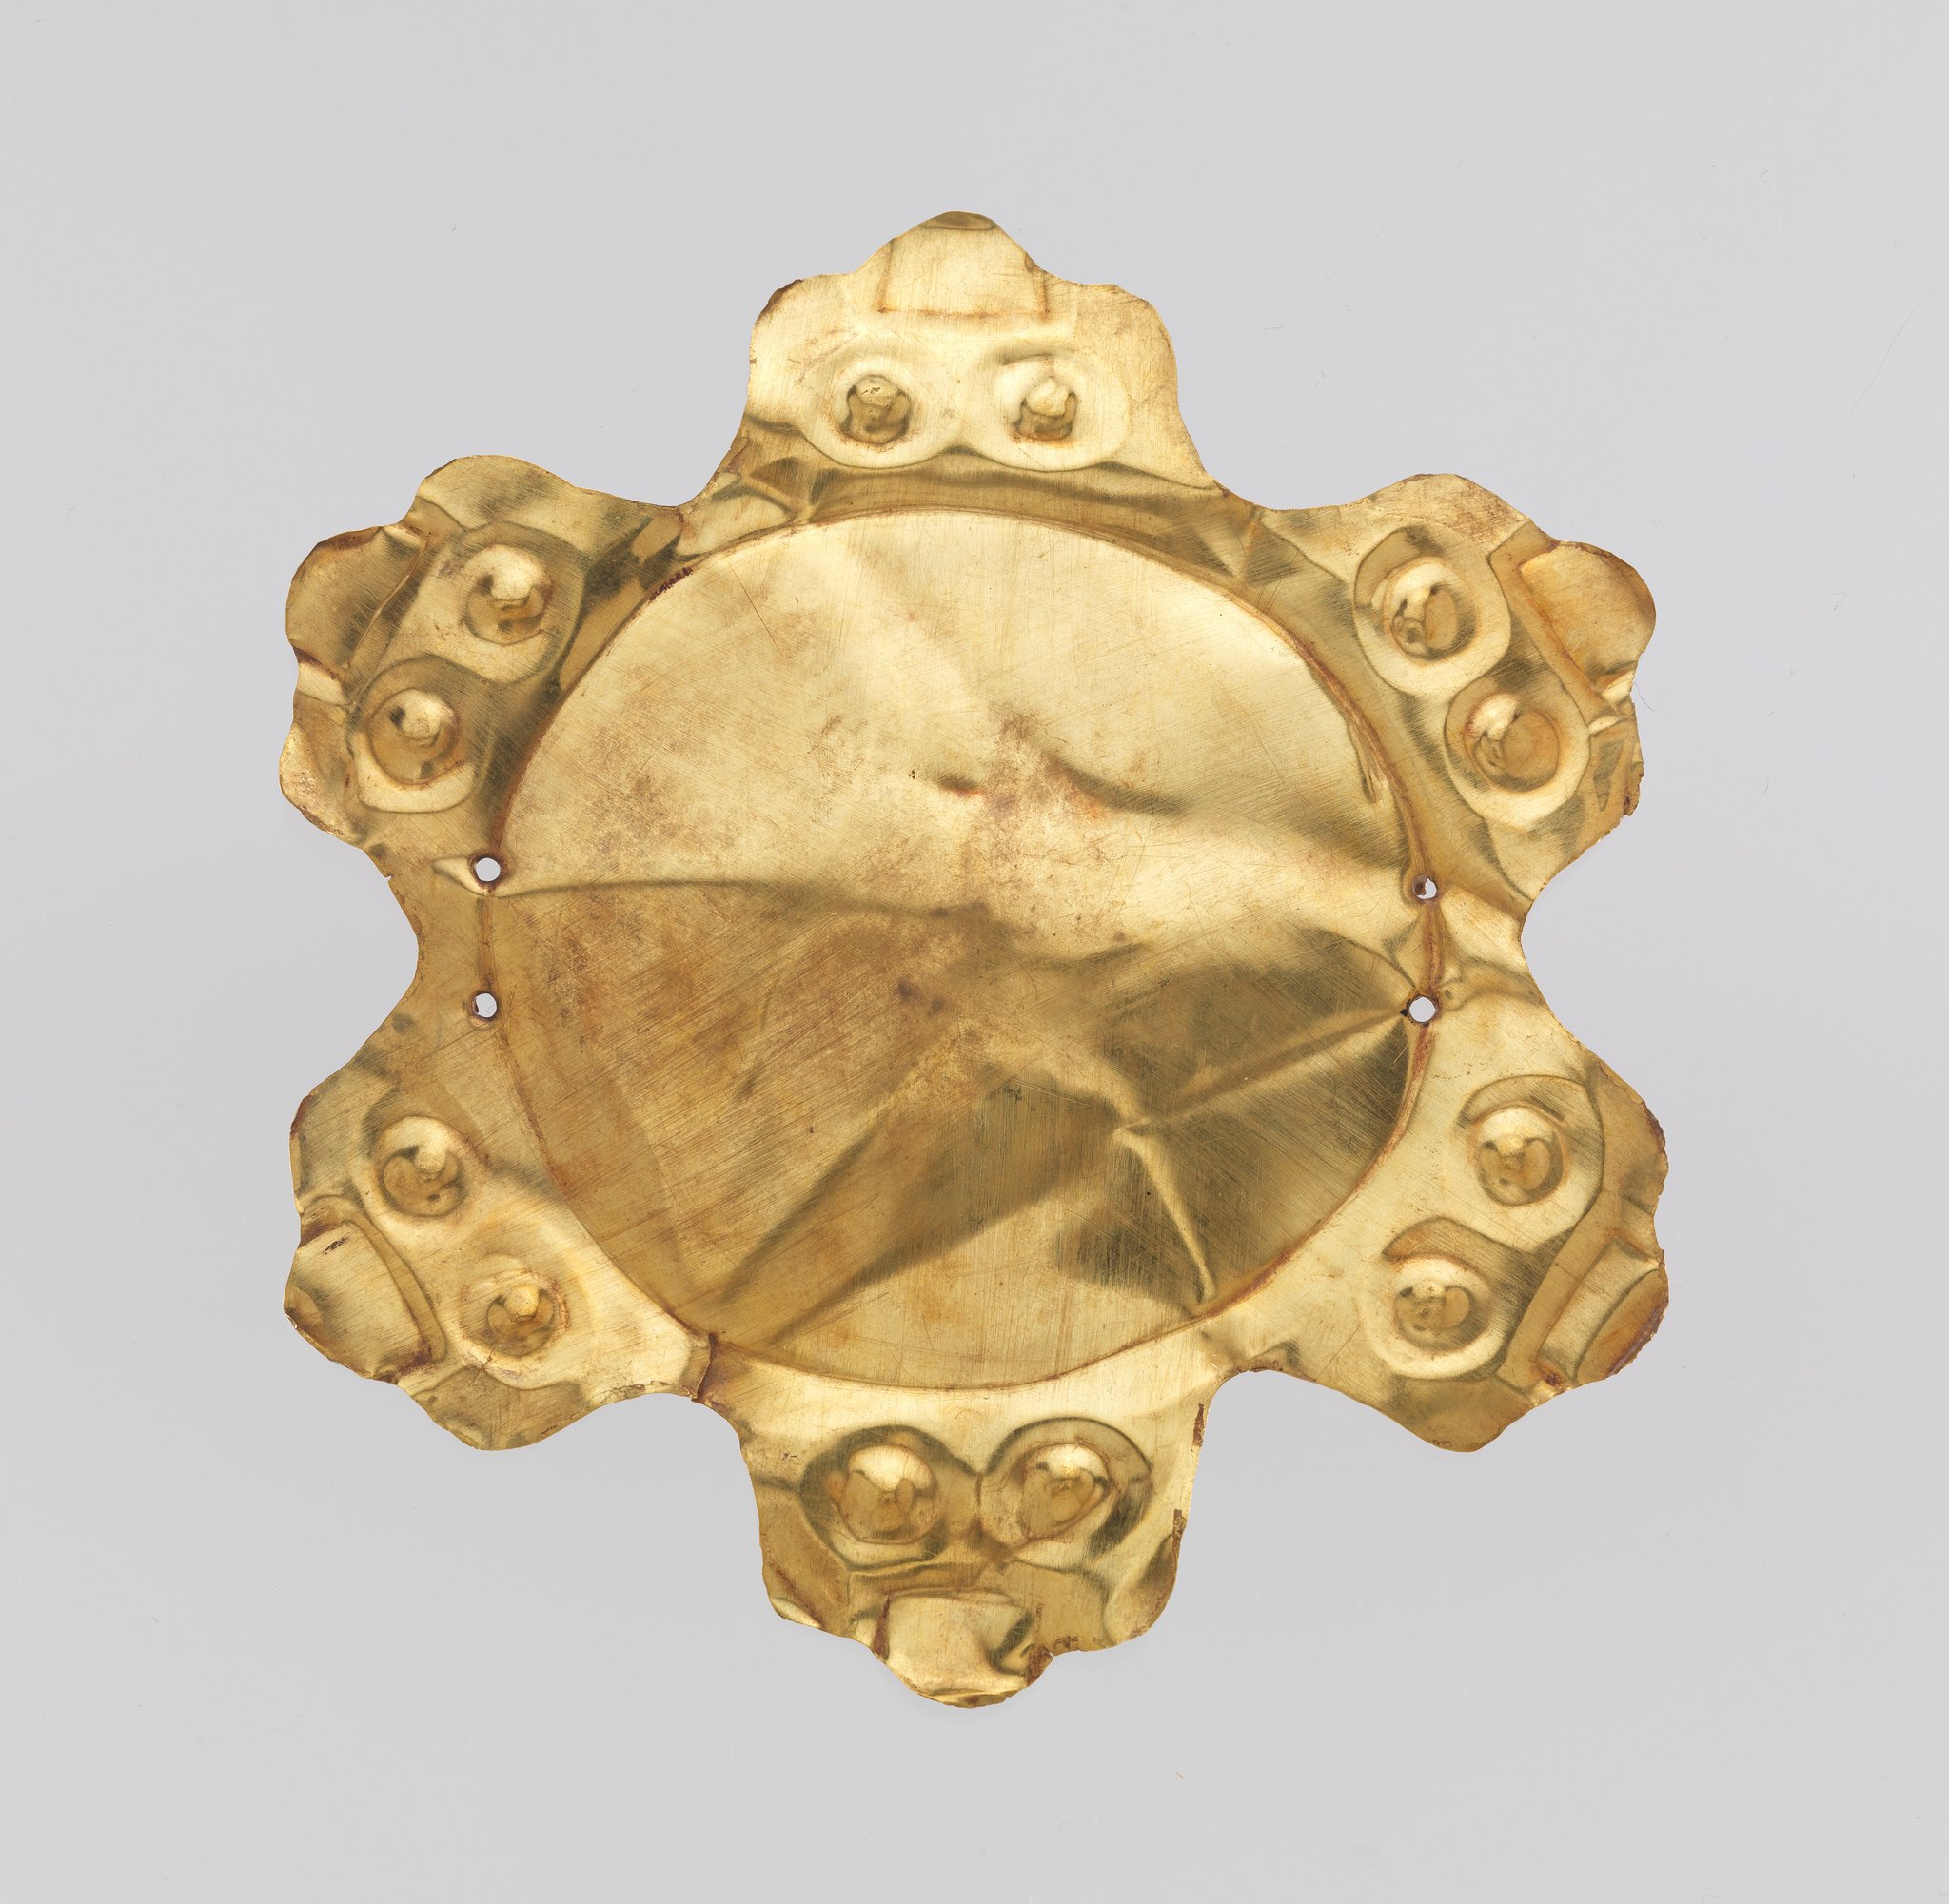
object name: ornament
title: Textile ornament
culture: nasca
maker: nasca artist(s)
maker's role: artist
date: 1-700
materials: gold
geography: peru